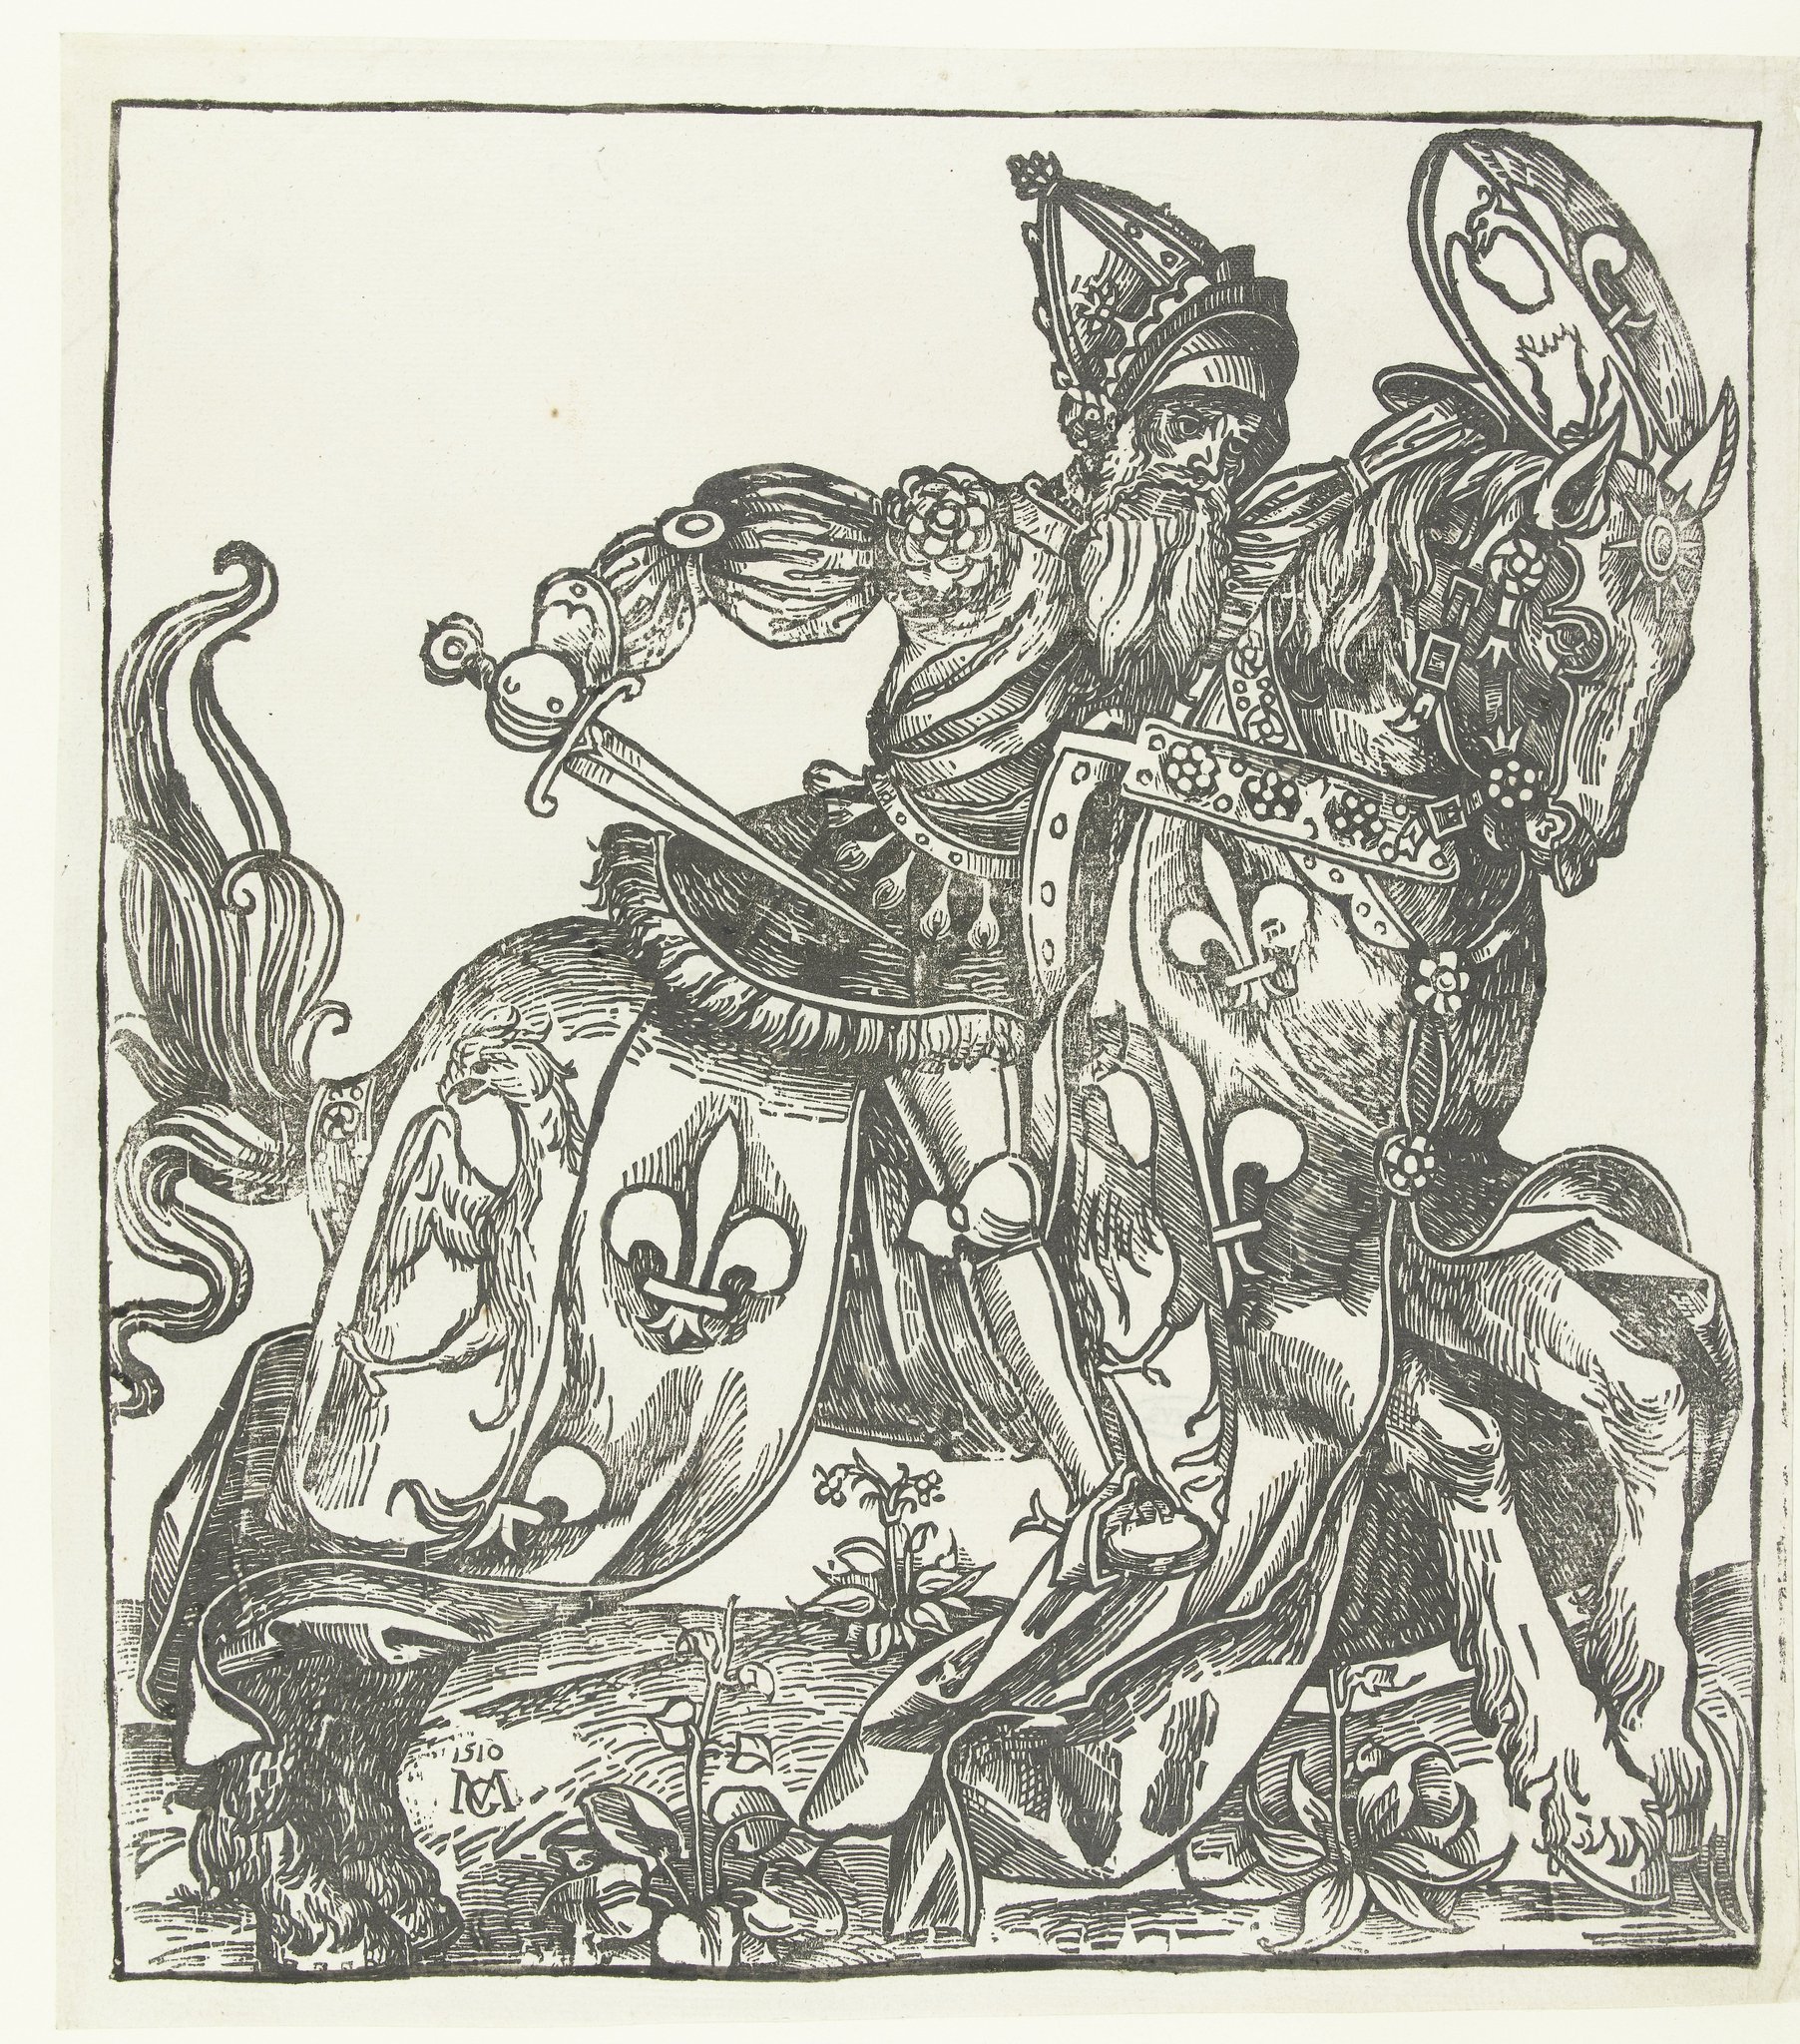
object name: print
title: Negen helden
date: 1500-1599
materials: paper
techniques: woodcut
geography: northern netherlands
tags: charlemagne (holy roman emperor), charlemagne (one of the nine worthies)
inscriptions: collector's mark: Lugt 2760, collector's mark: Lugt 2228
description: Ruiter in galop, het wapen van Karel de Grote op het schild en op het wapenkleed. Op het hoofd een helm met keizerskroon. 19e-eeuwse herdruk van van een 16e-eeuws blok.